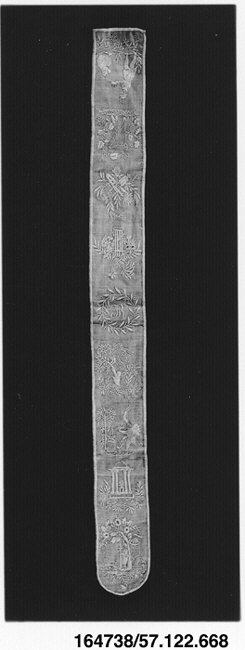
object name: sampler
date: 1801-1900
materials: cotton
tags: flowers,leaves